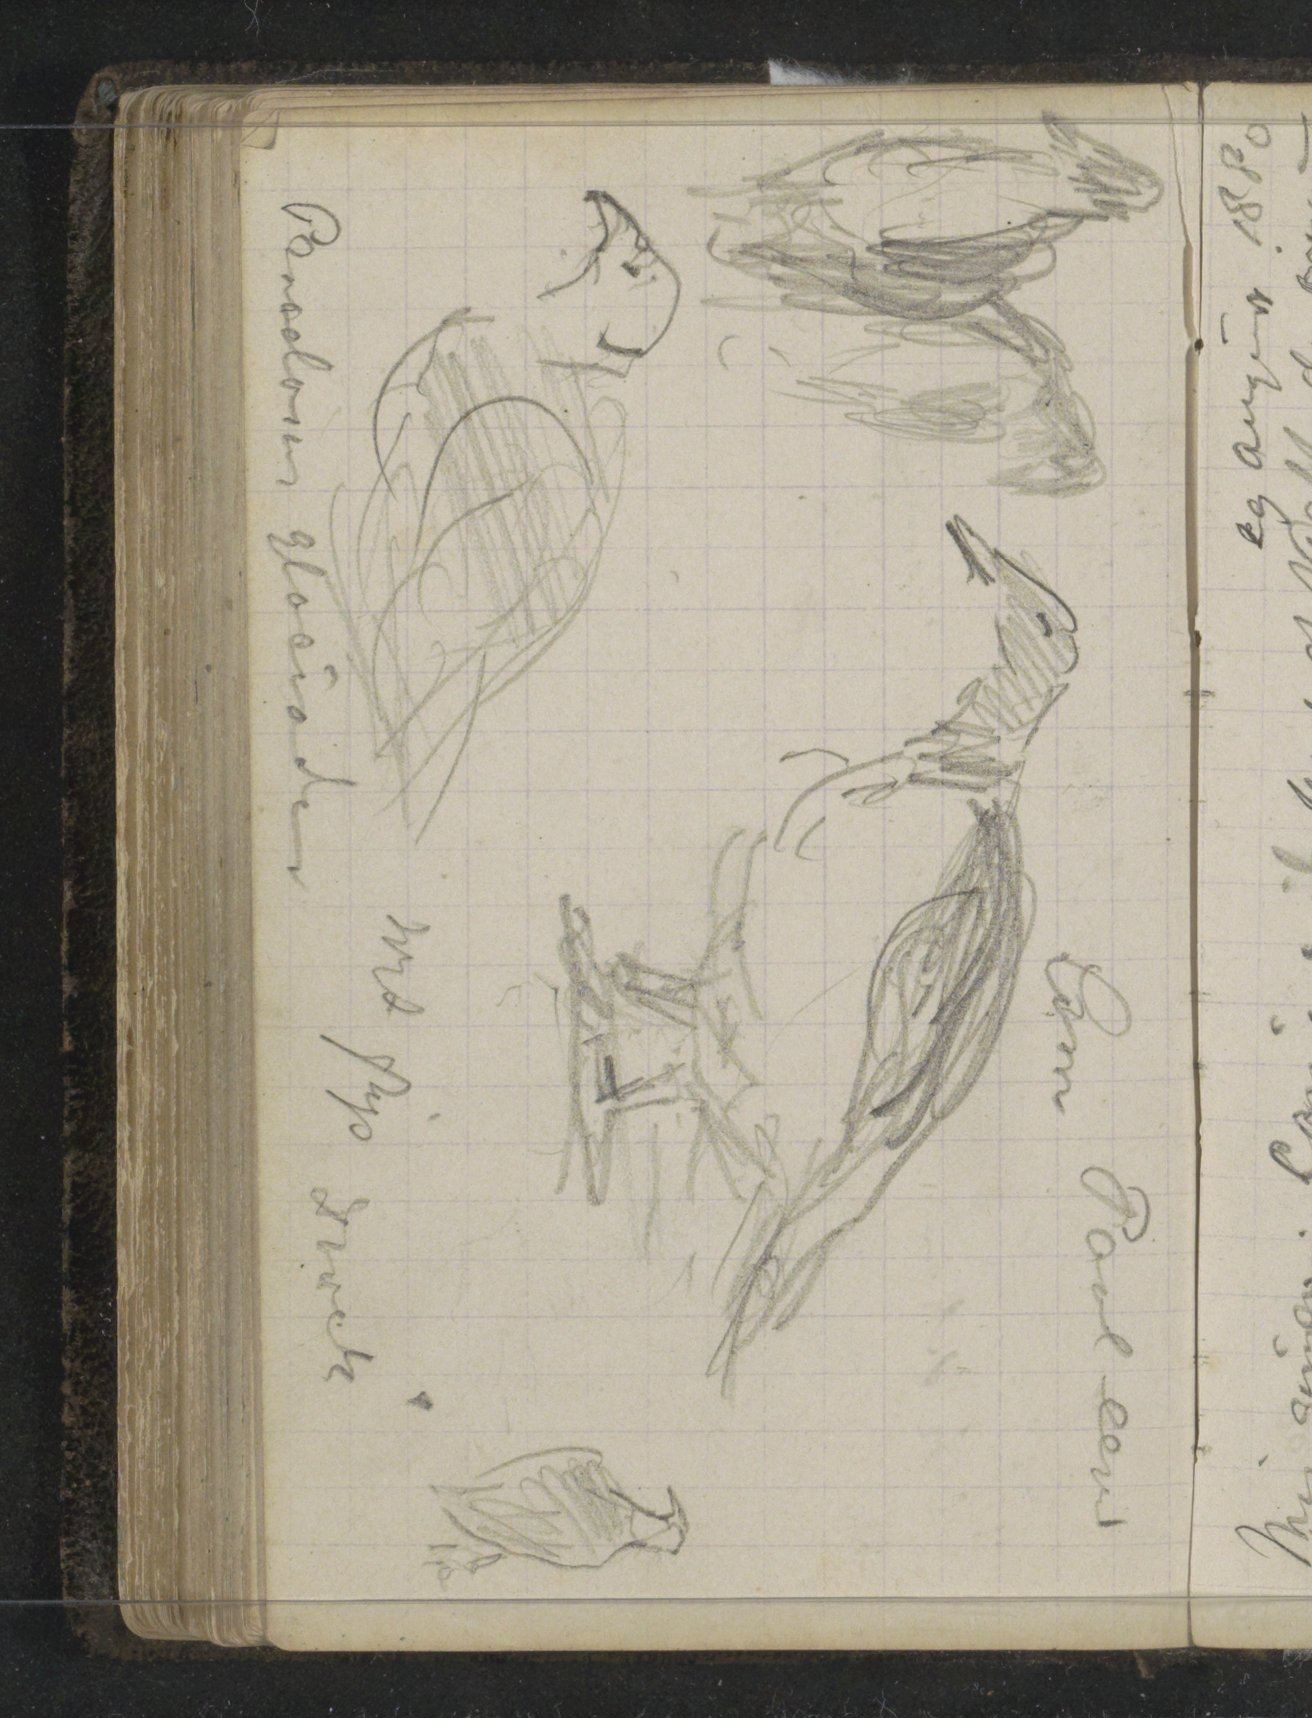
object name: sketchbook leaf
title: Poolvogels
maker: louis apol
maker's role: draughtsman, painter, print maker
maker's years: 1850-1936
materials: pencil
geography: novaya zemlya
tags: birds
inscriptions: annotation: ‘Lom / Pool eend / [...] glacialis’, : ‘wit grijs’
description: Onder andere een kortbekzeekoet (lom). Blad 82 verso uit een schetsboek met 110 bladen betekend tijdens de expeditie naar Nova Zembla in 1880.